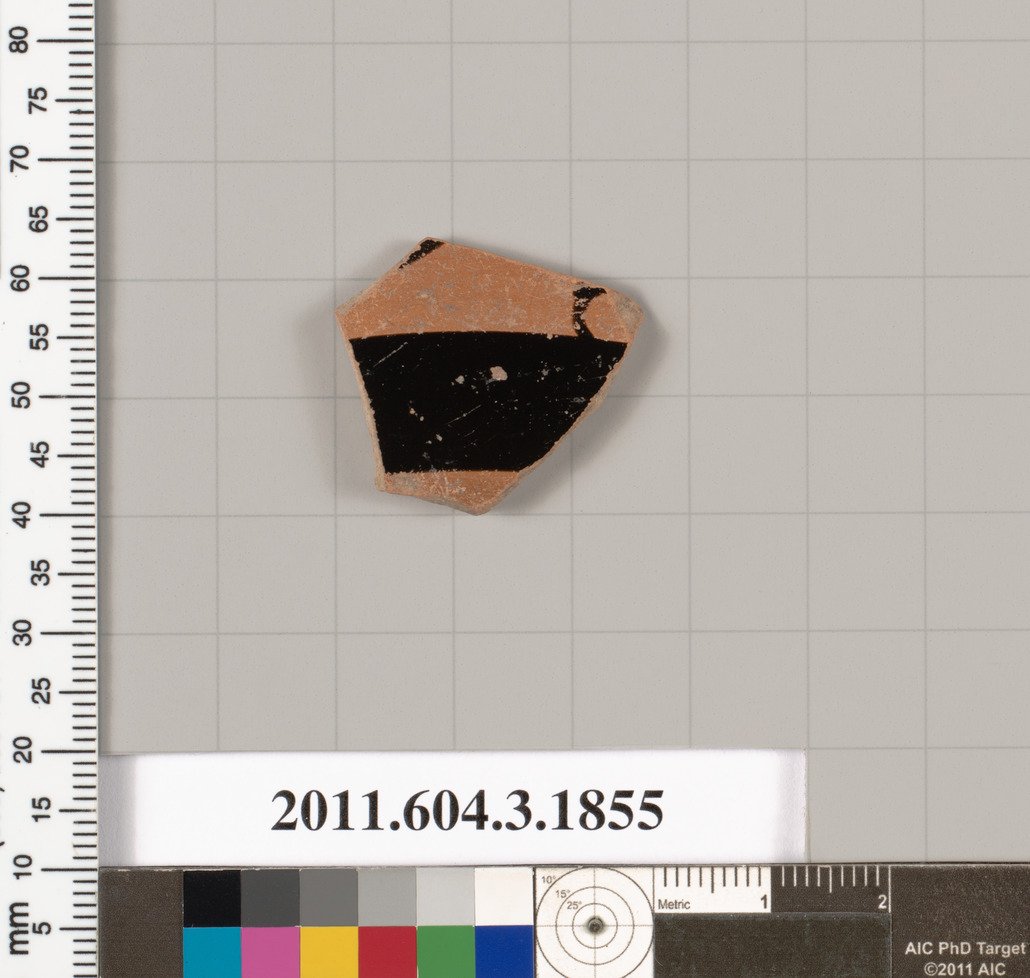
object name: kylix fragment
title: Terracotta fragment of a kylix: Lip cup (drinking cup)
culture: greek, attic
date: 550-526 BCE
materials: terracotta